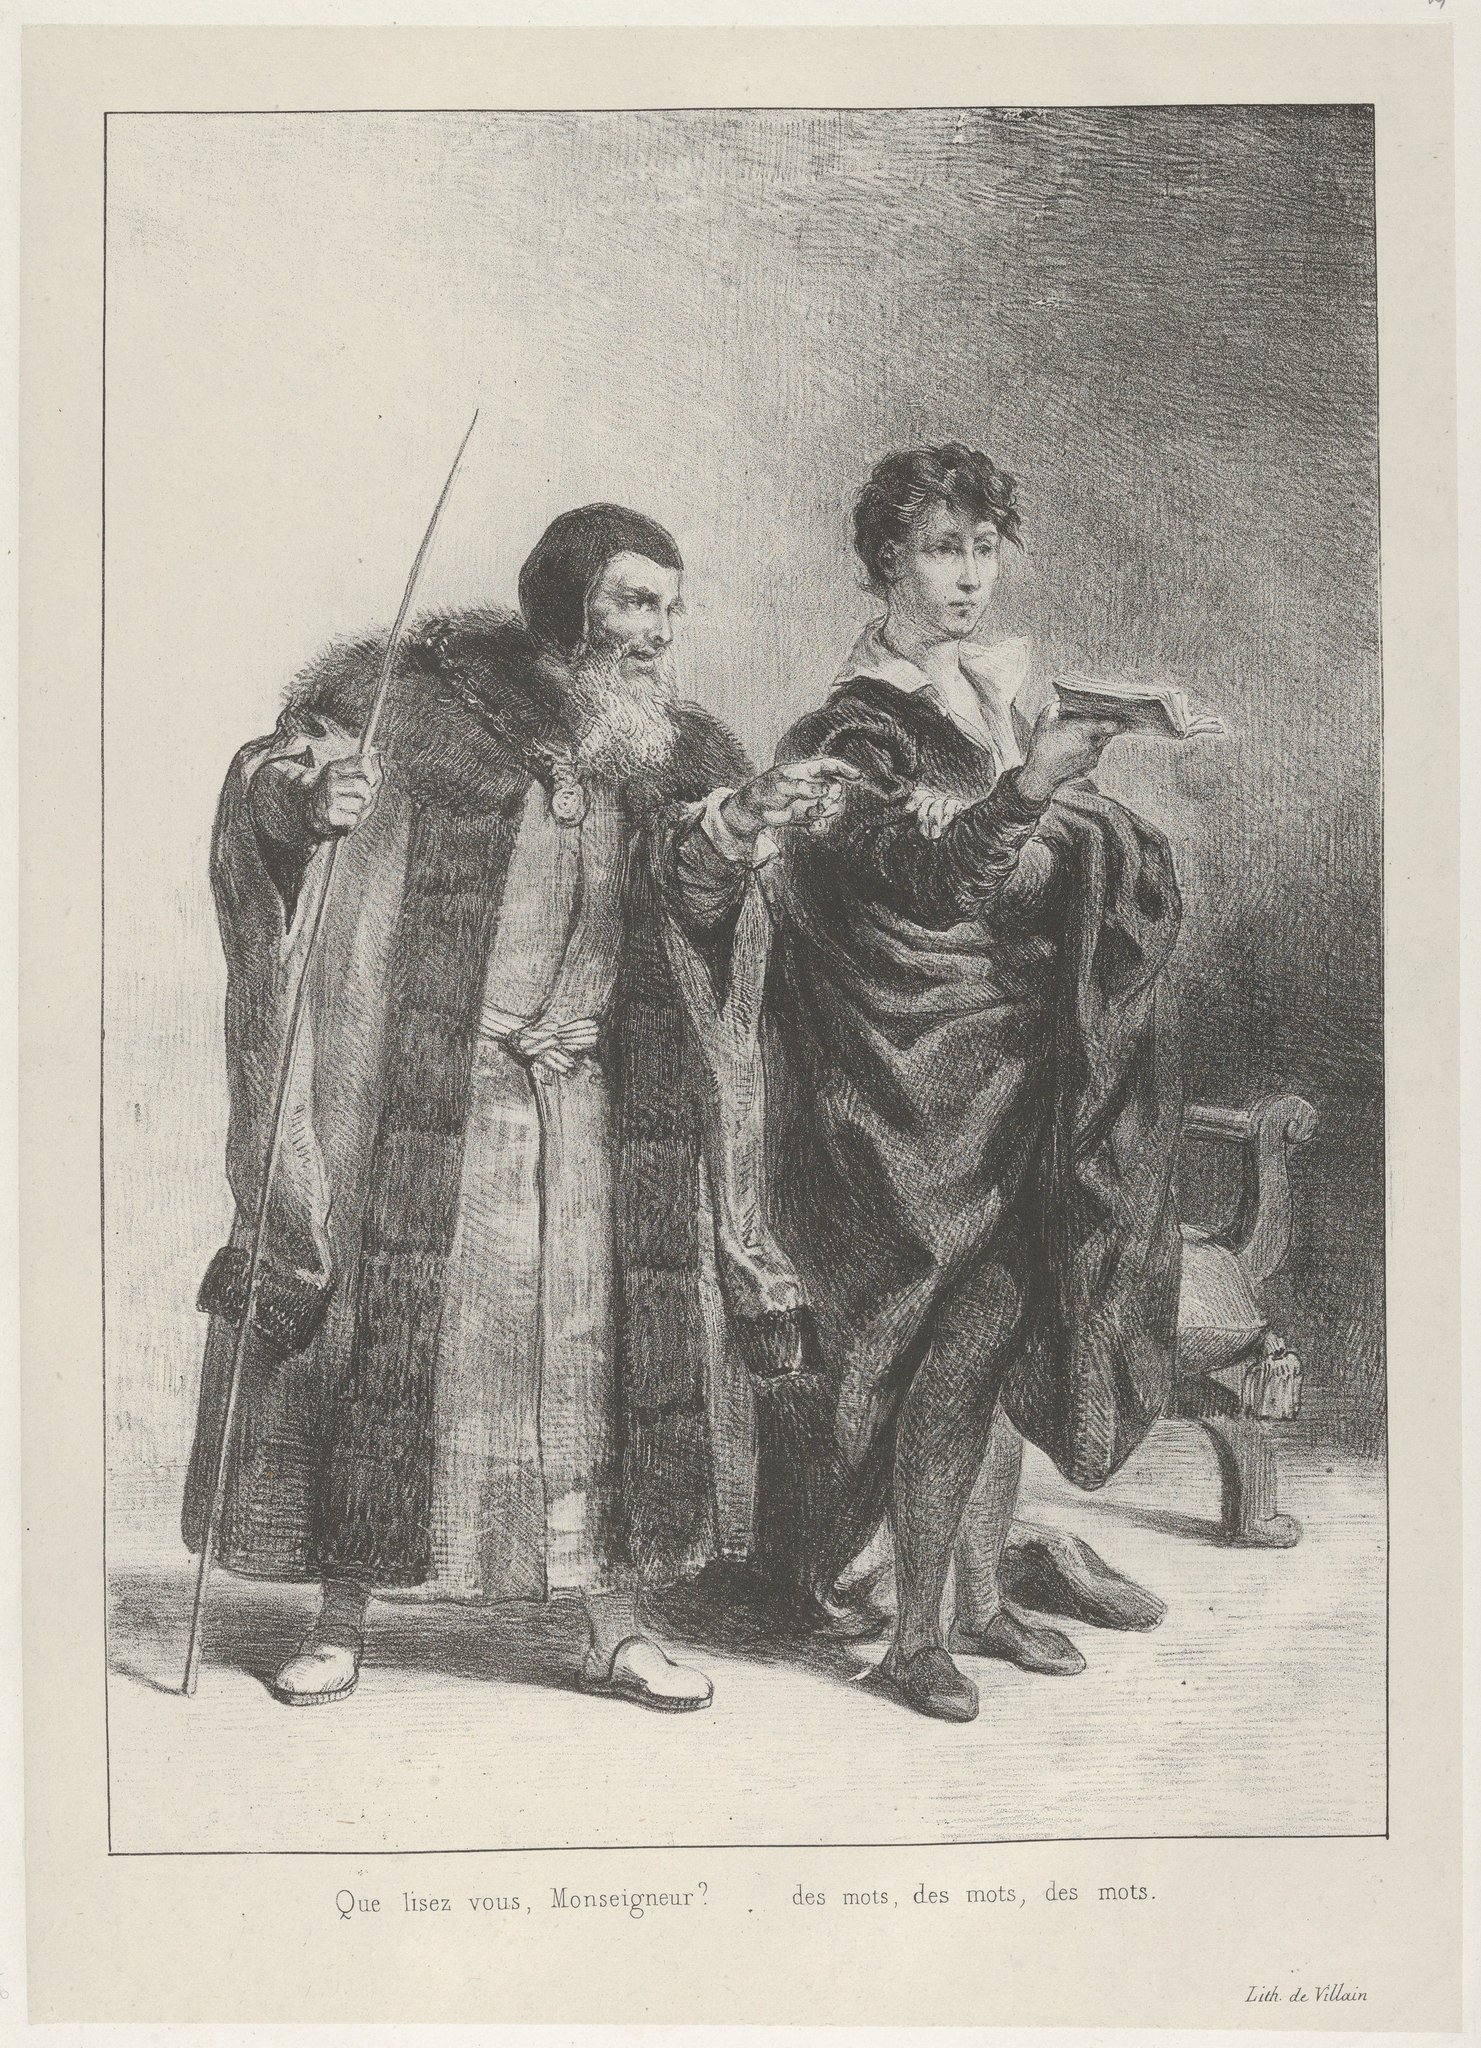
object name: print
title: Polonius and Hamlet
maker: eugène delacroix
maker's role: artist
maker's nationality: french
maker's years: 1798-1863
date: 1834-1843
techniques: lithograph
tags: princes,shakespeare,men,hamlet